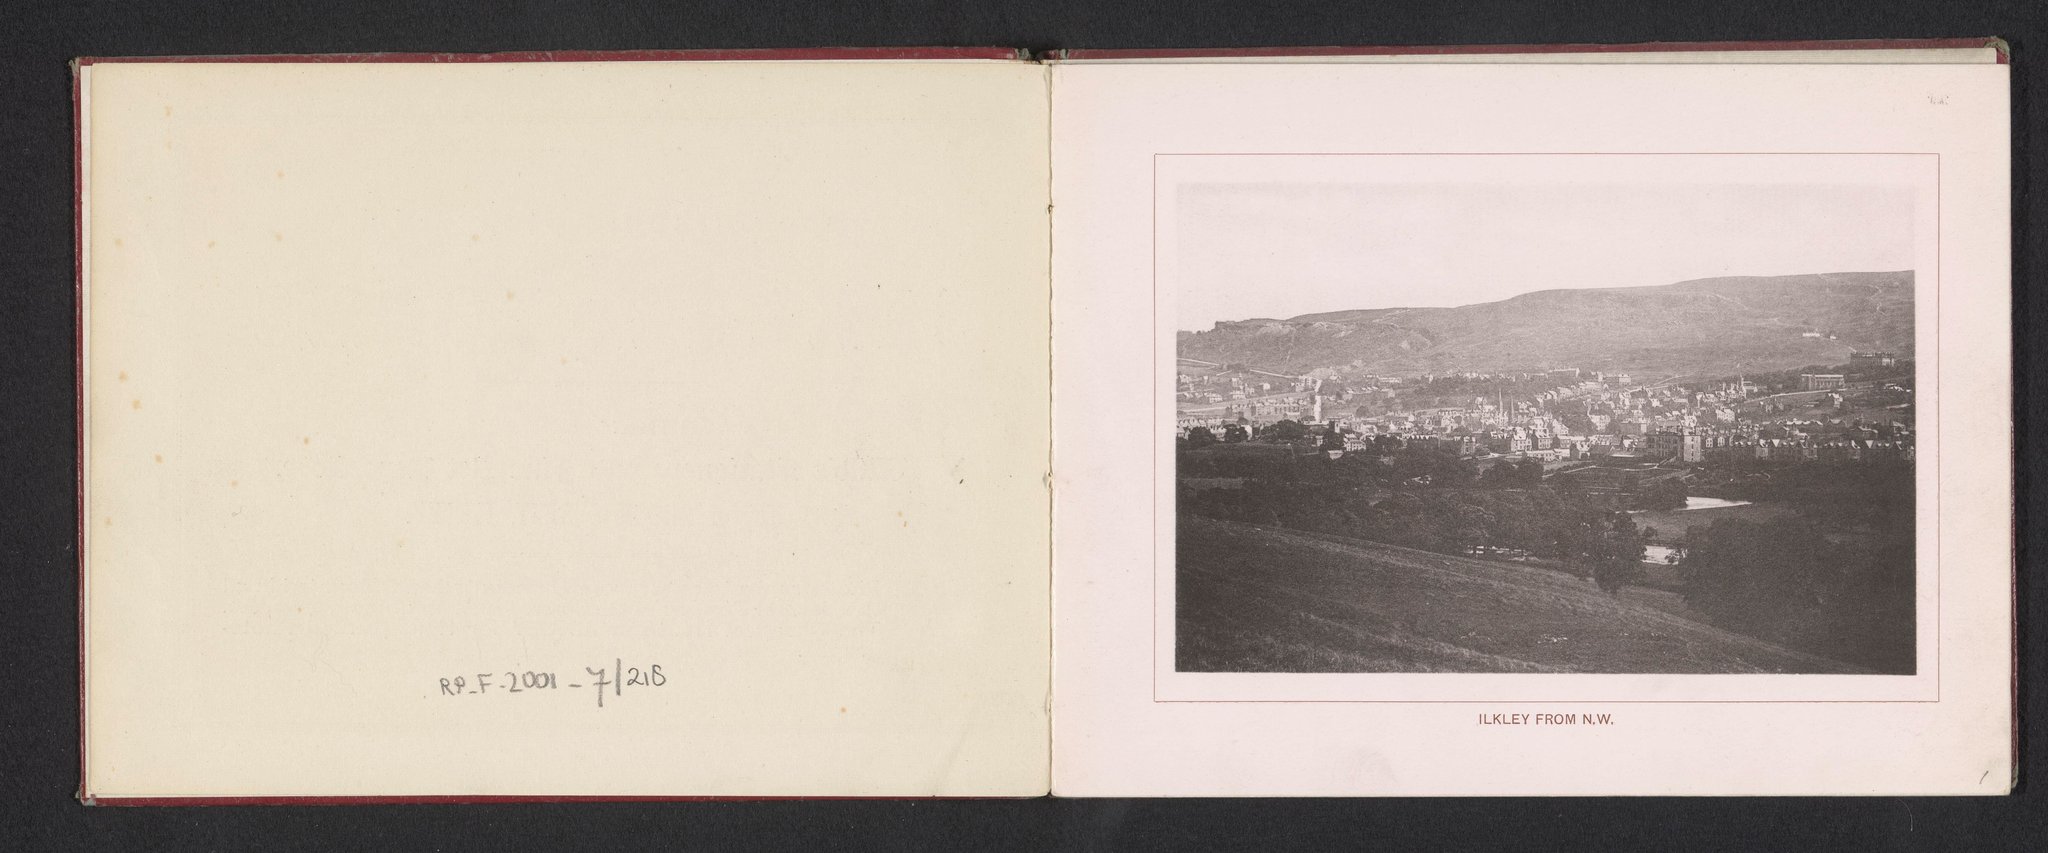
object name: photomechanical print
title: Ilkley from N.W.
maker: Anonymous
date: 1890-1900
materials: paper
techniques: photograph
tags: city-view in general; 'veduta'